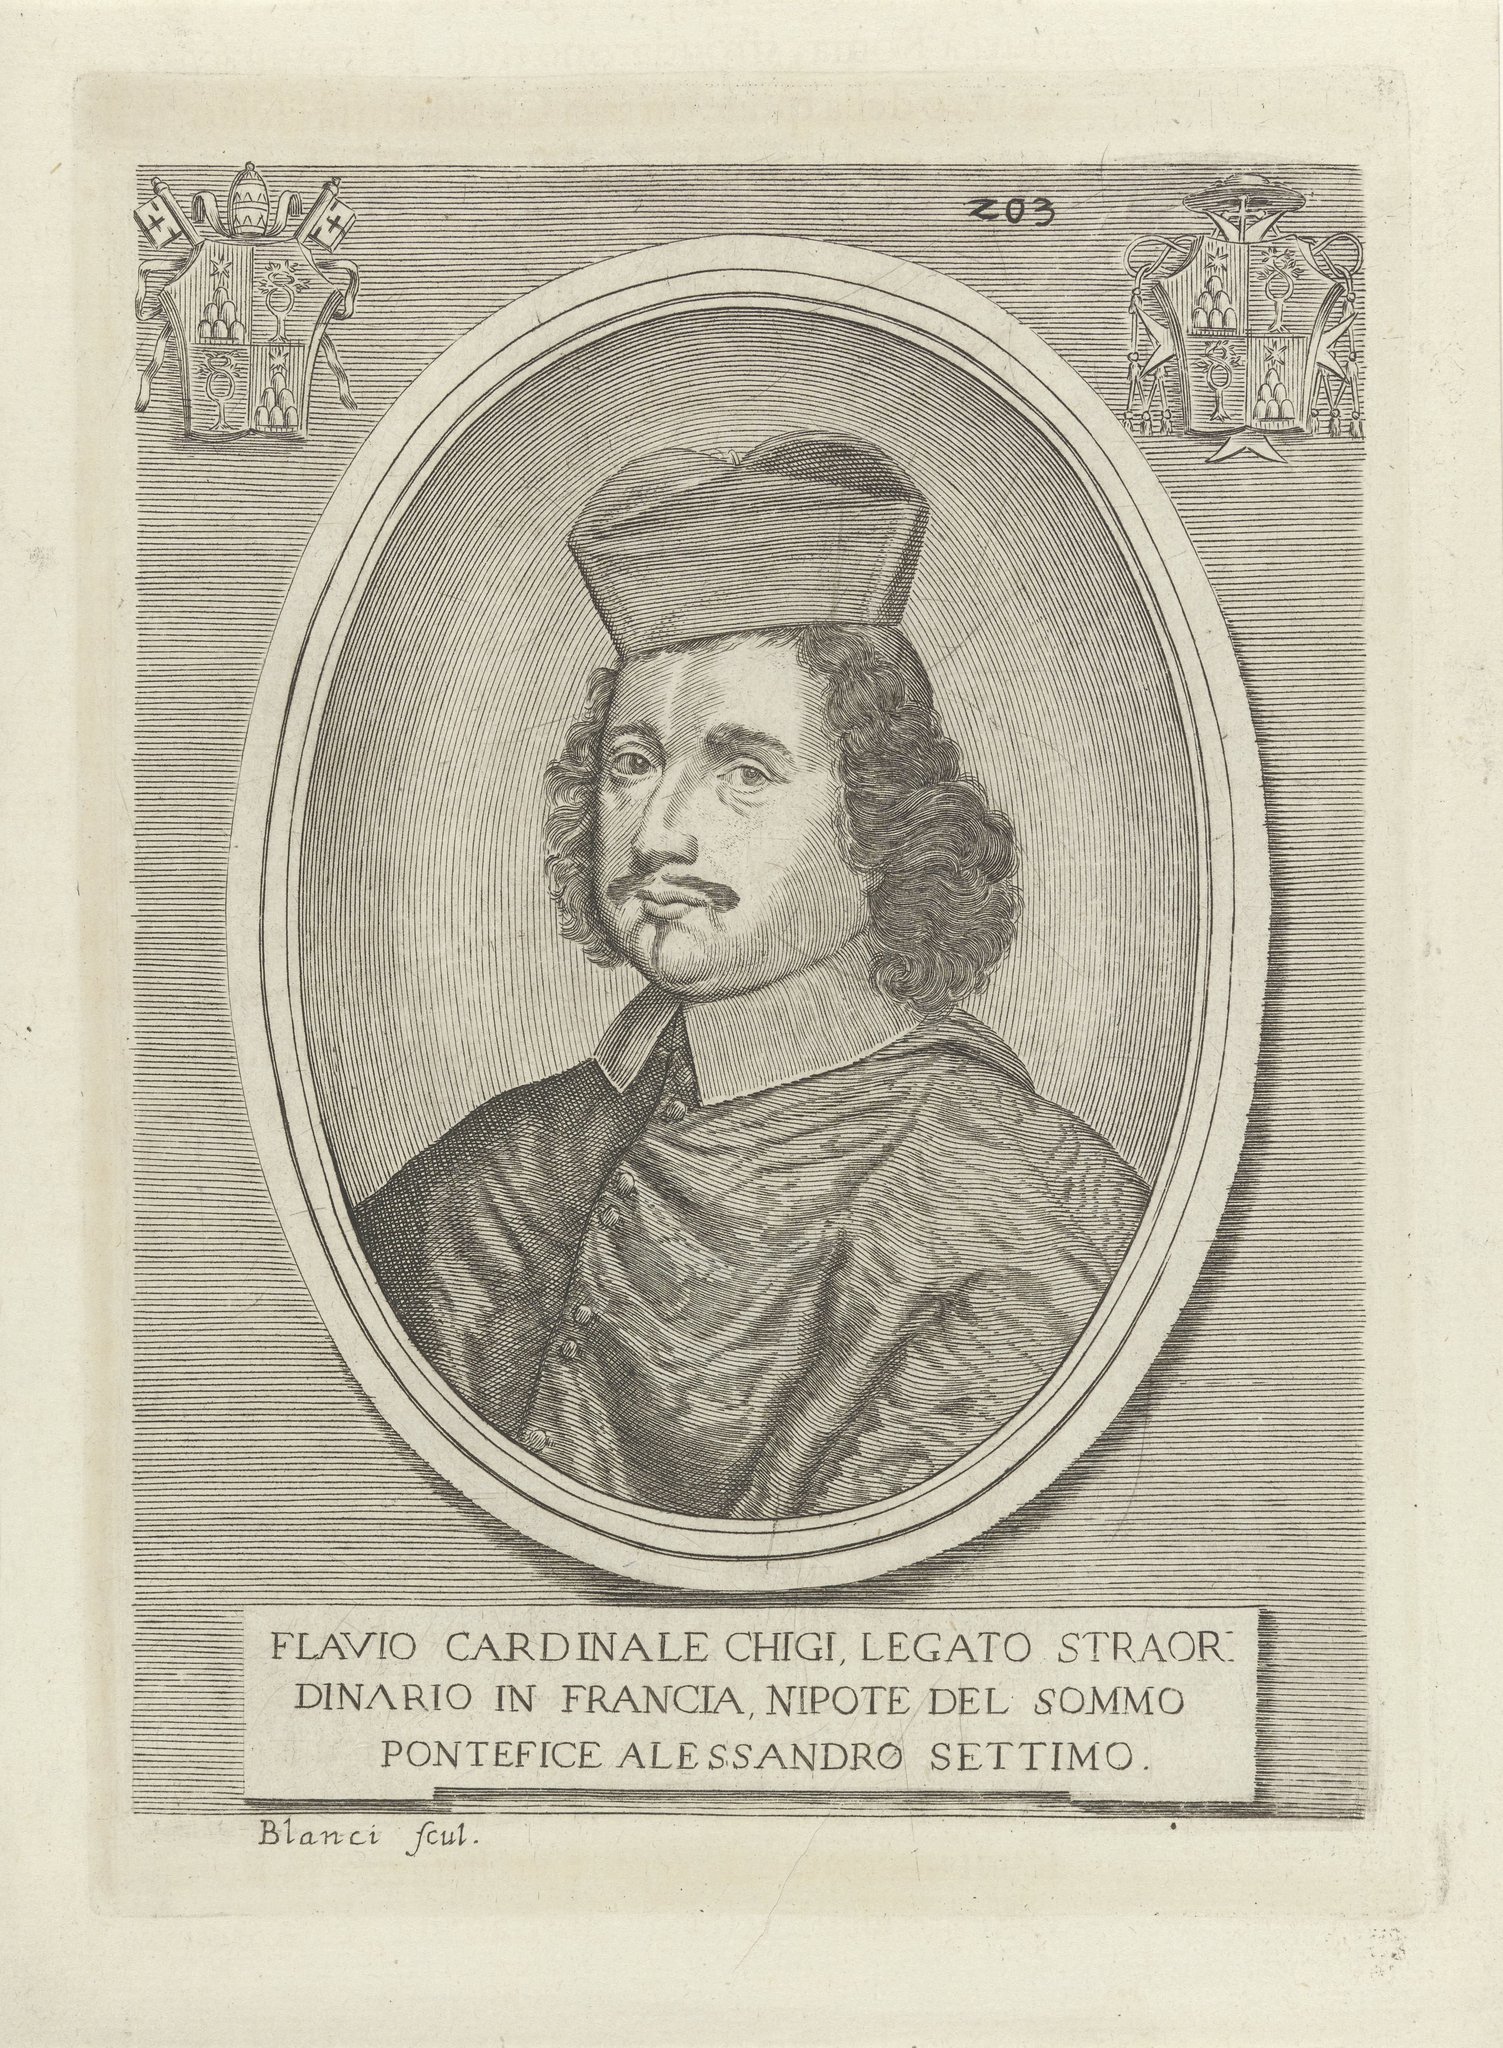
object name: print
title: Portret van kardinaal Flavio Chigi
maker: giulio cesare bianchi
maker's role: print maker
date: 1771-1781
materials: paper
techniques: engraving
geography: italy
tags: rome, flavio chigi, cardinal, historical persons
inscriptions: collector's mark: Lugt 2228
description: Prent uit een reeks van portretten van kardinalen.